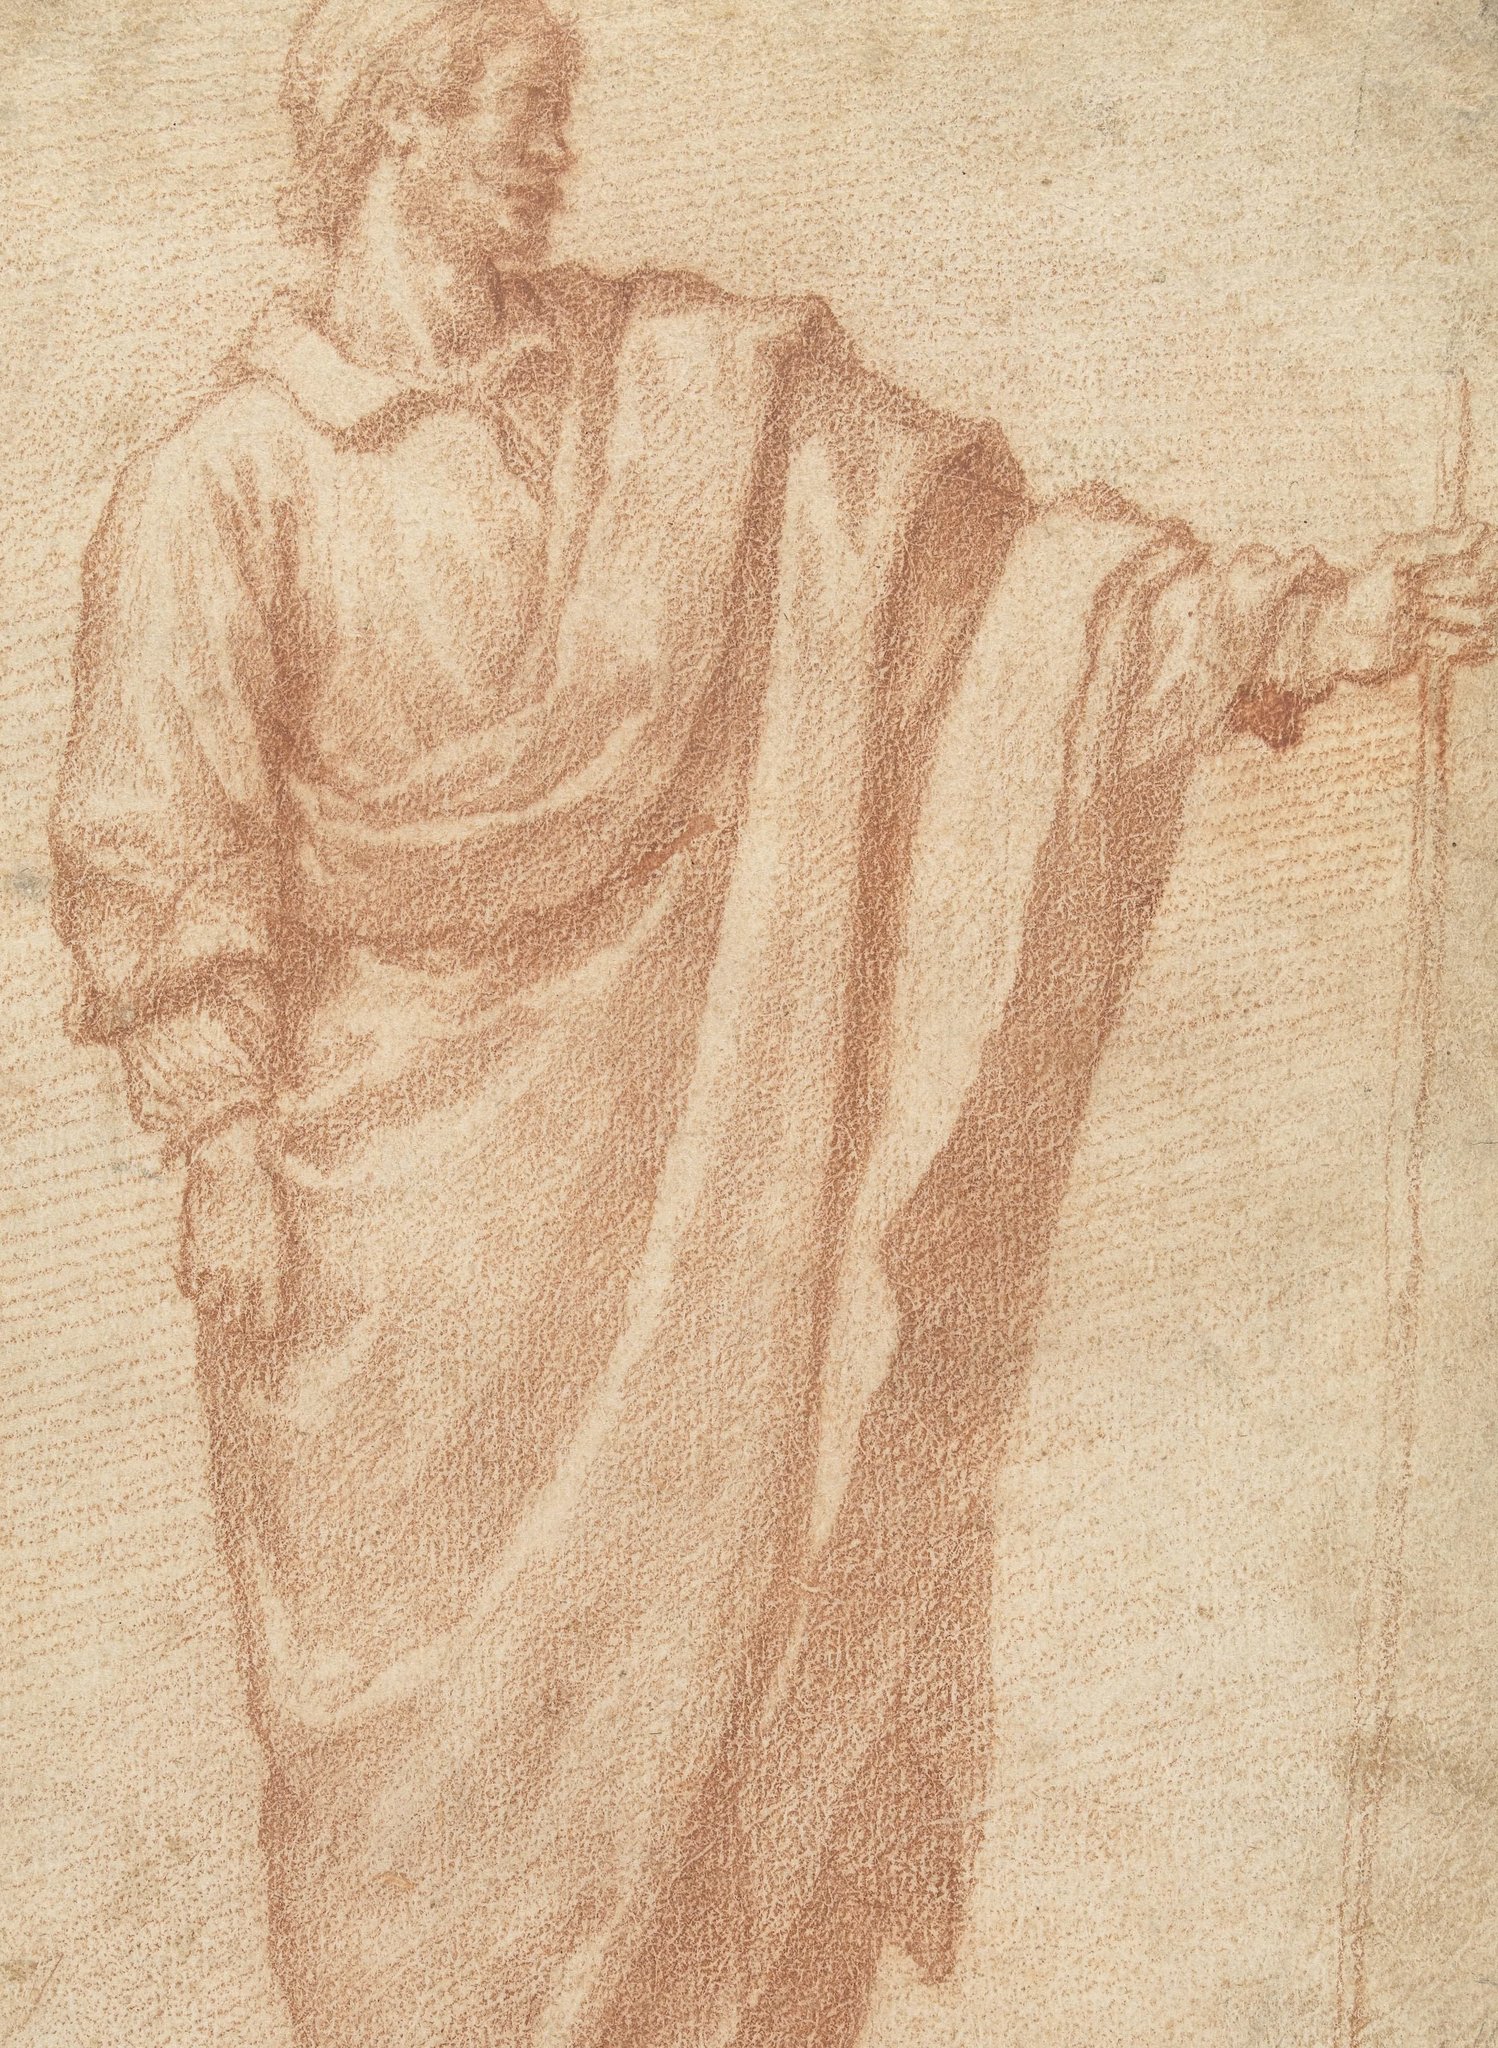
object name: drawing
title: Studie van een gedrapeerde figuur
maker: matteo rosselli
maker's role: draughtsman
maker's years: 1578-1651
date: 1588-1650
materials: chalk, paper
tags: standing figure